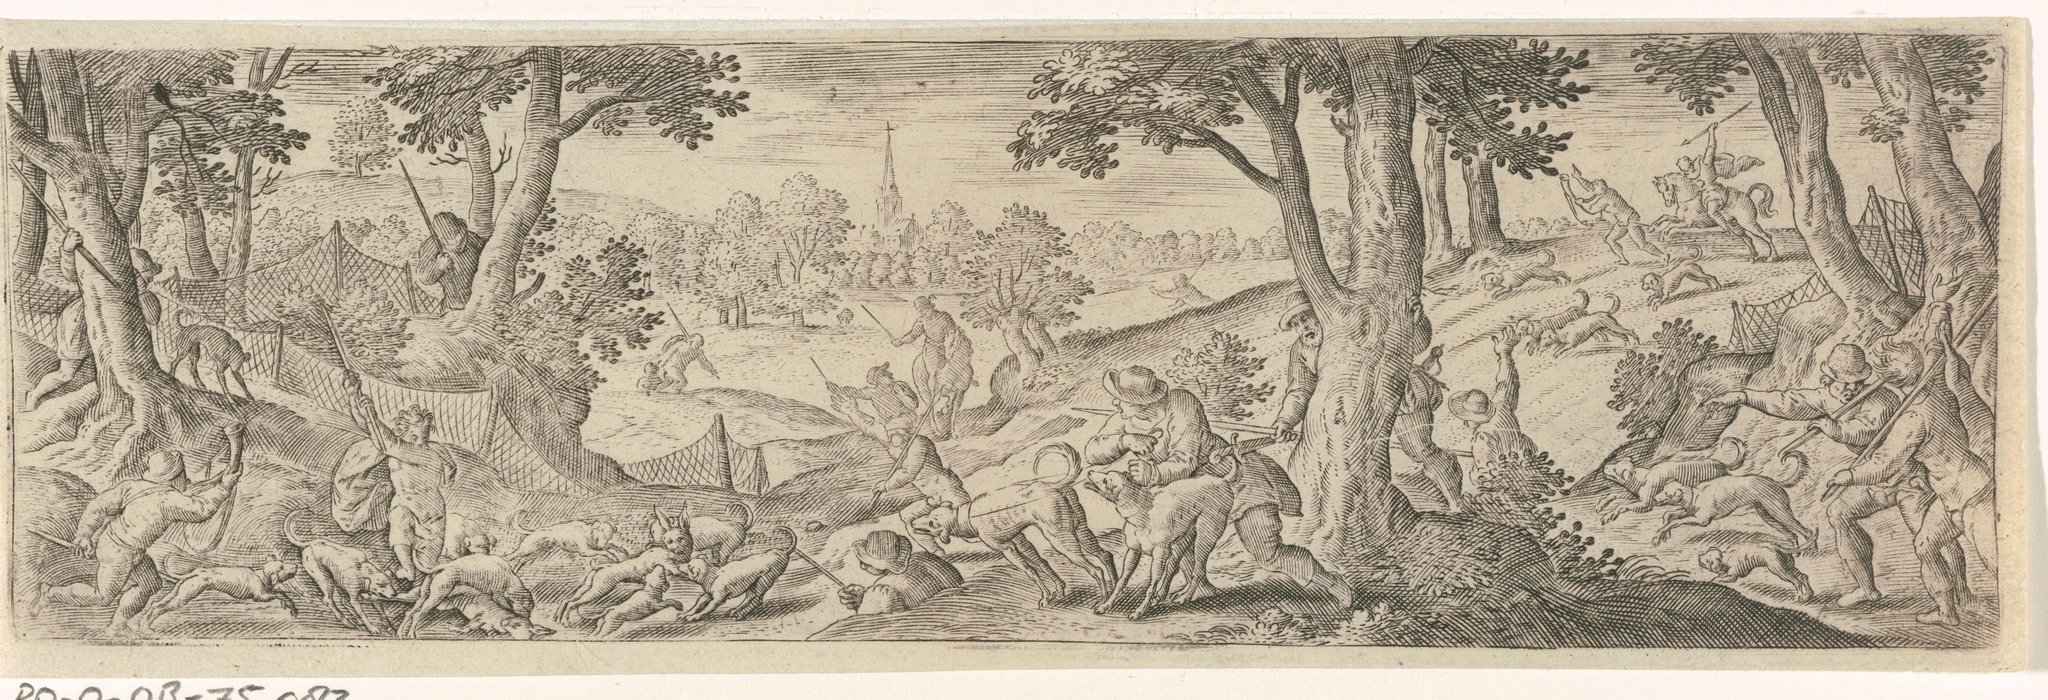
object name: print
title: Landschap met hazenjacht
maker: Anonymous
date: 1580-1650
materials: paper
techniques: engraving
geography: netherlands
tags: hare-hunting, rabbit-hunting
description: Landschap met jagers gewapend met speren en jachthonden. In het midden twee ingesloten hazen.